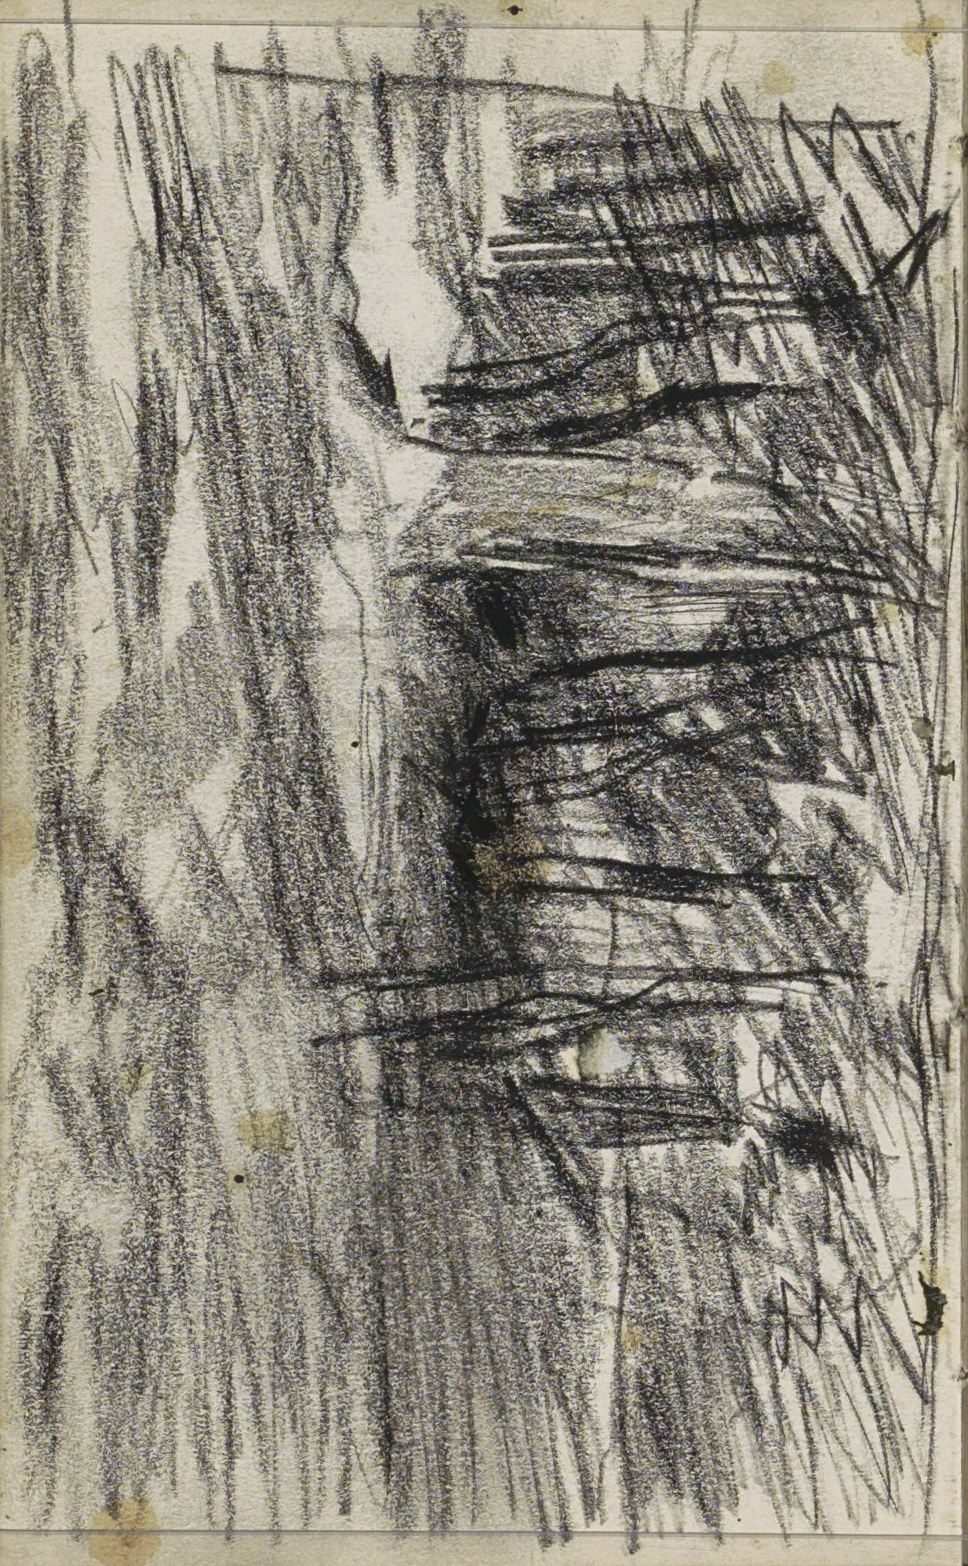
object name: sketchbook leaf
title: Rand van een bos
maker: anton mauve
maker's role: draughtsman, painter, print maker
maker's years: 1838-1888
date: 1848-1888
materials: chalk, paper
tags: forest, wood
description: Blad 46 verso uit een schetsboek met 53 bladen.